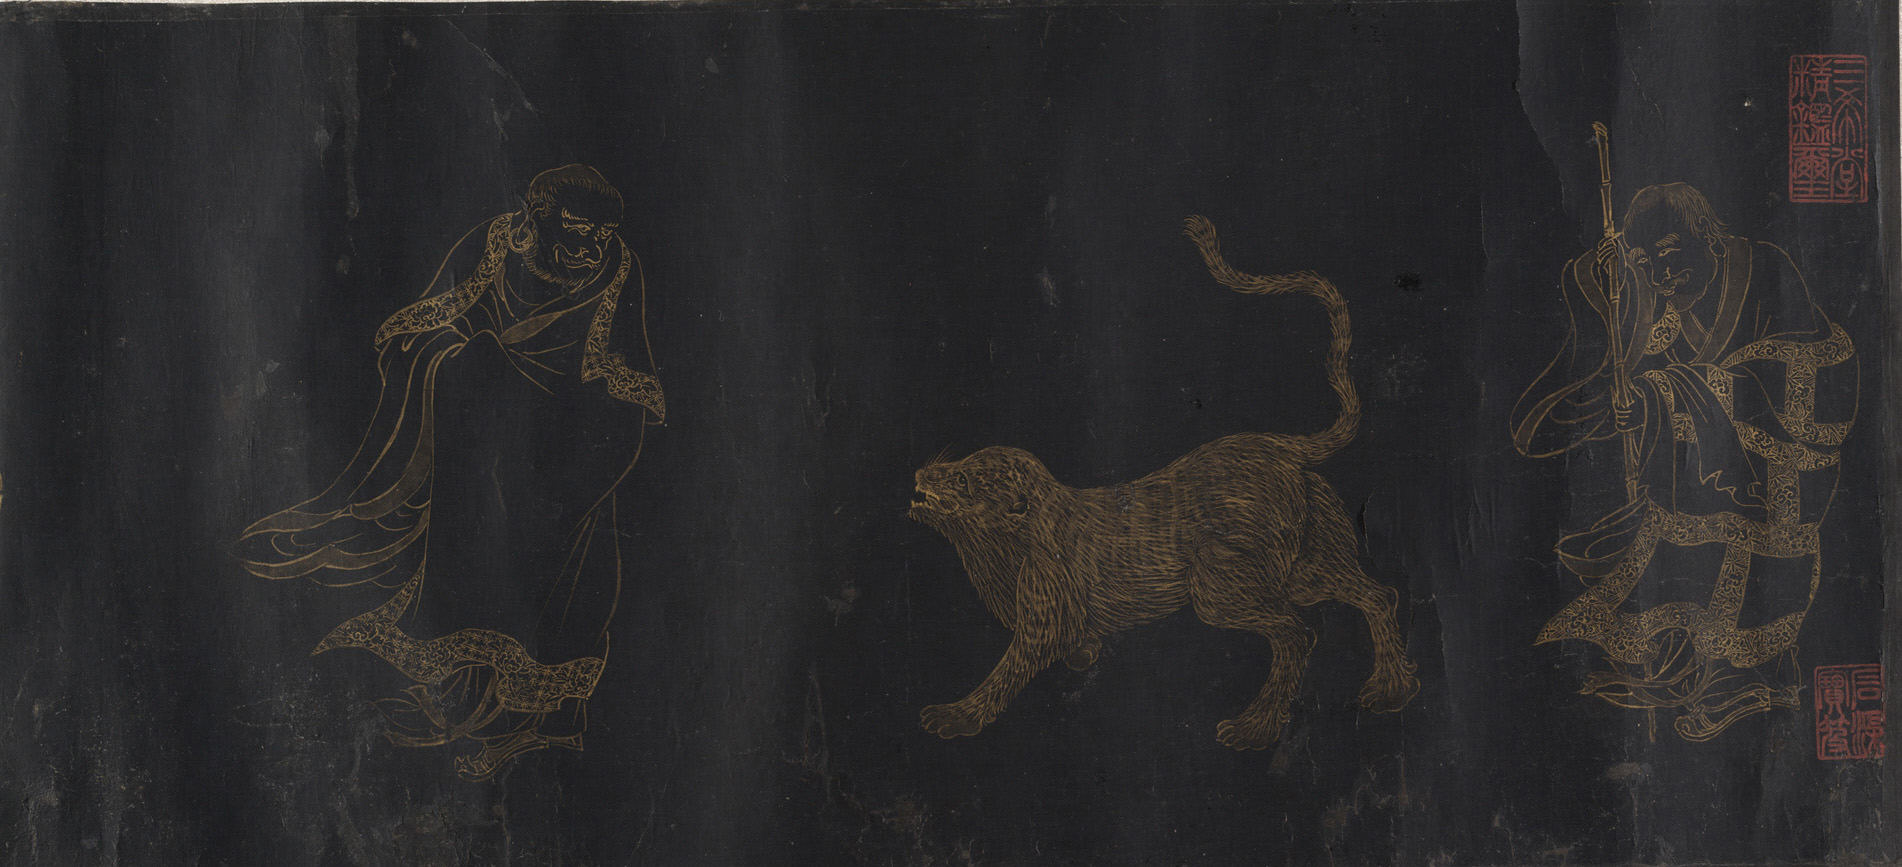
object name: handscroll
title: Buddhist Scroll: The Eighteen Luohans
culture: chinese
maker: unidentified artist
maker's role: artist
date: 1368-1911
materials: gold, paper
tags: animals,men,buddhism